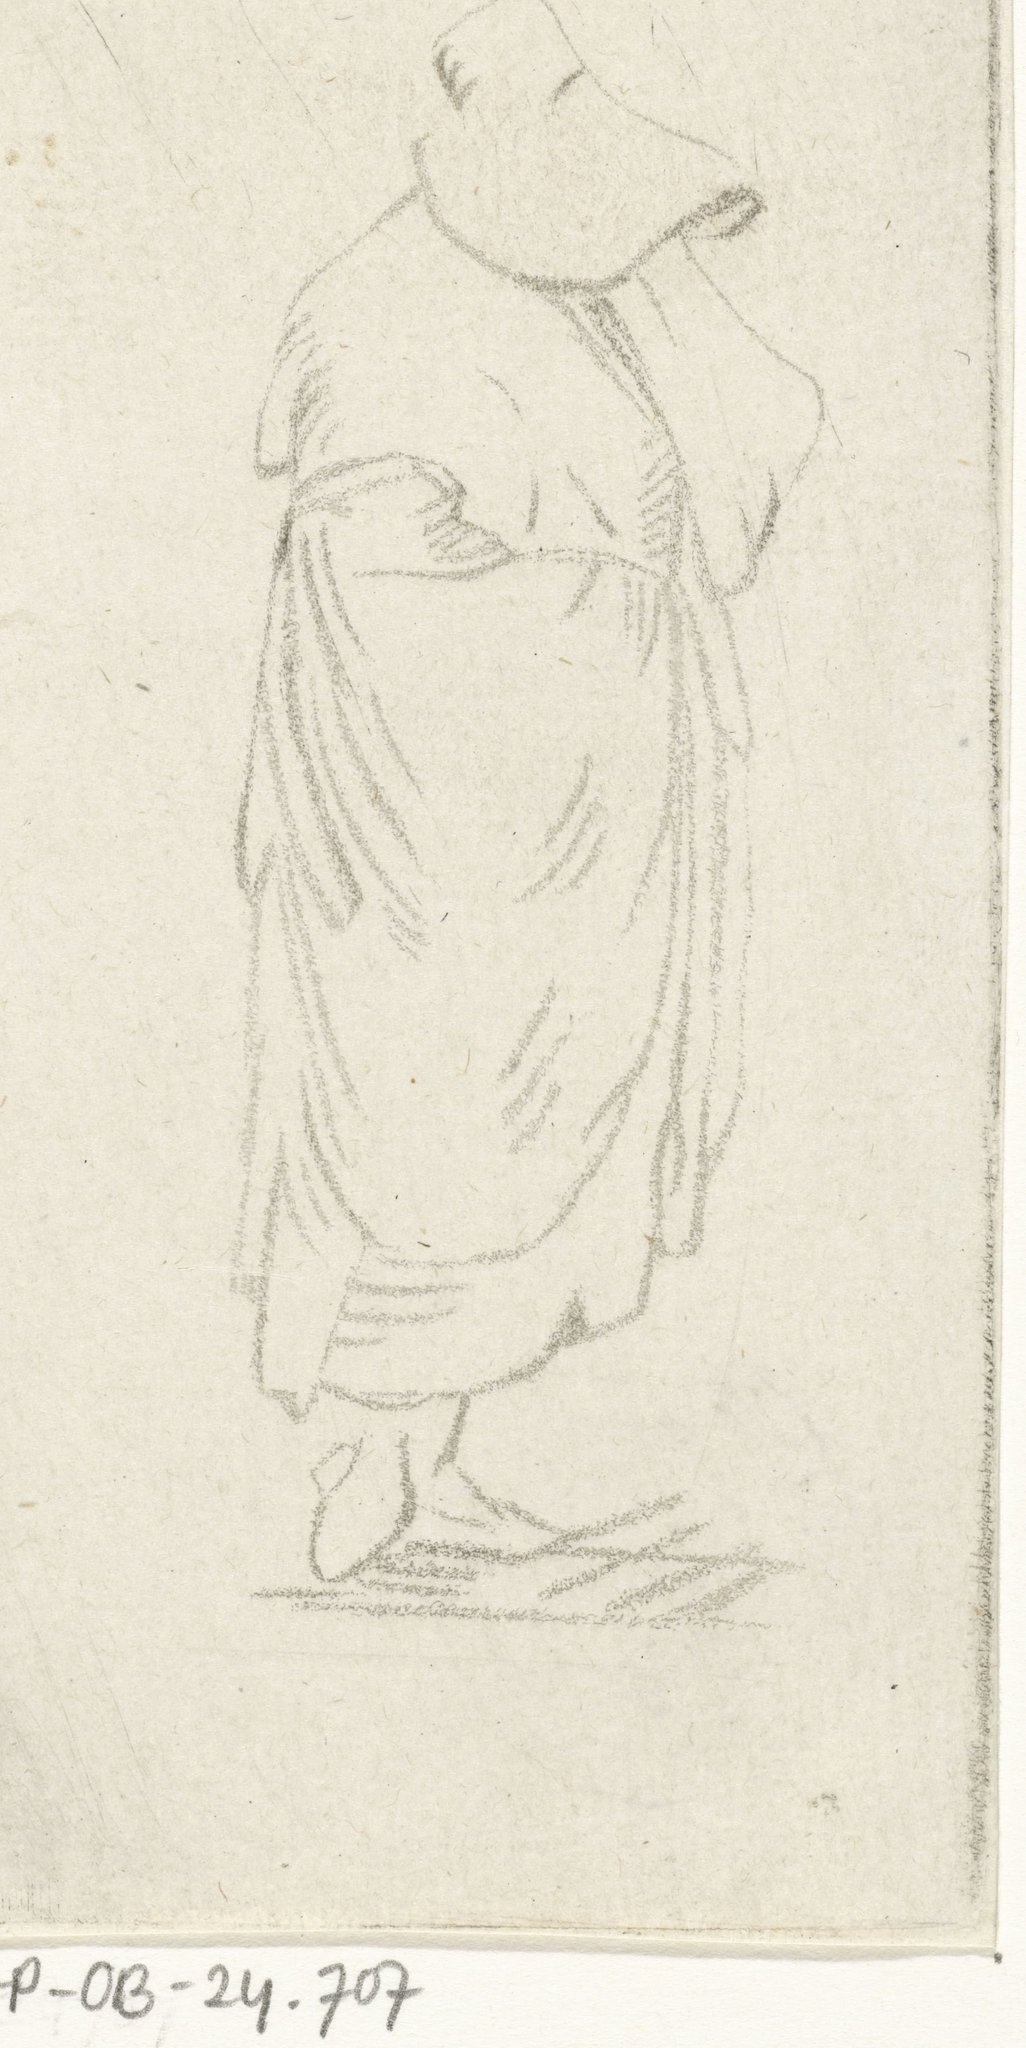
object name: print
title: Staande vrouw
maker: cornelis ploos van amstel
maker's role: draughtsman, print maker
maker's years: 1726-1798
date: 1736-1798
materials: paper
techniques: printmaking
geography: amsterdam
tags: adult woman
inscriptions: collector's mark: Lugt 240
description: Staande vrouw, die een zakdoek tegen haar gezicht houdt.